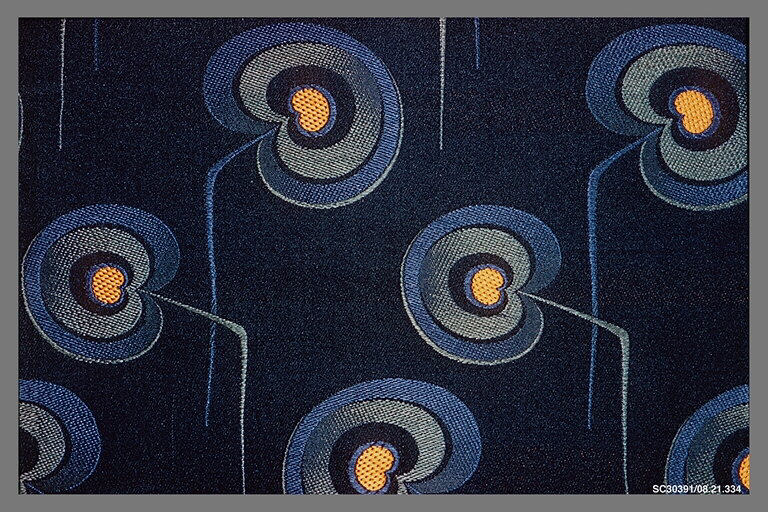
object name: textile sample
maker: Anonymous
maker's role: designer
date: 1900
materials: silk